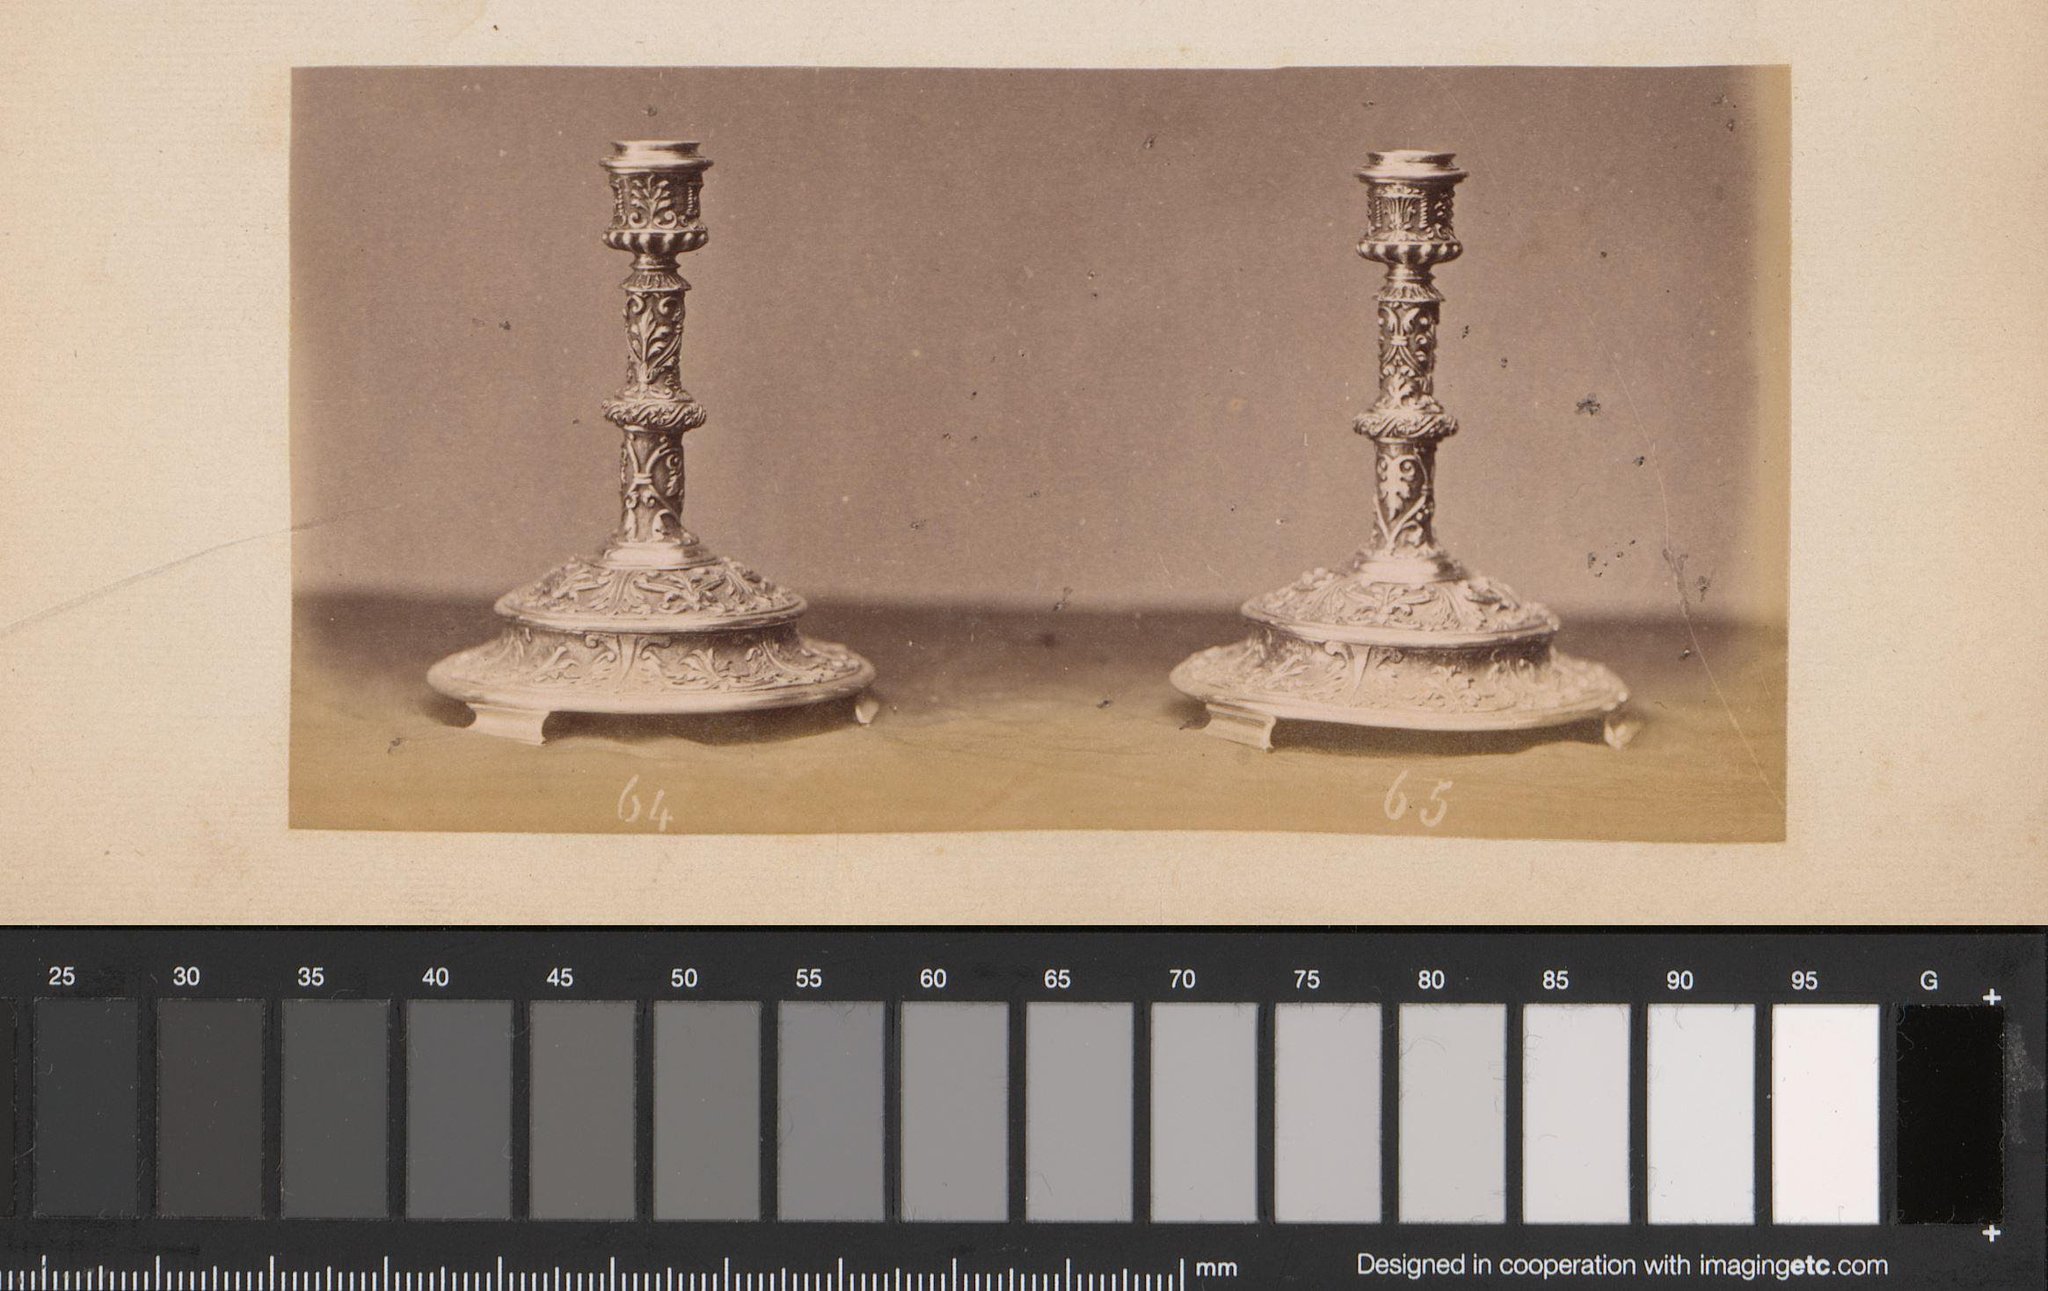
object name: photograph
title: Twee metalen kandelaars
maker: Anonymous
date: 1860-1885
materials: photographic support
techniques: albumen print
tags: candlestick